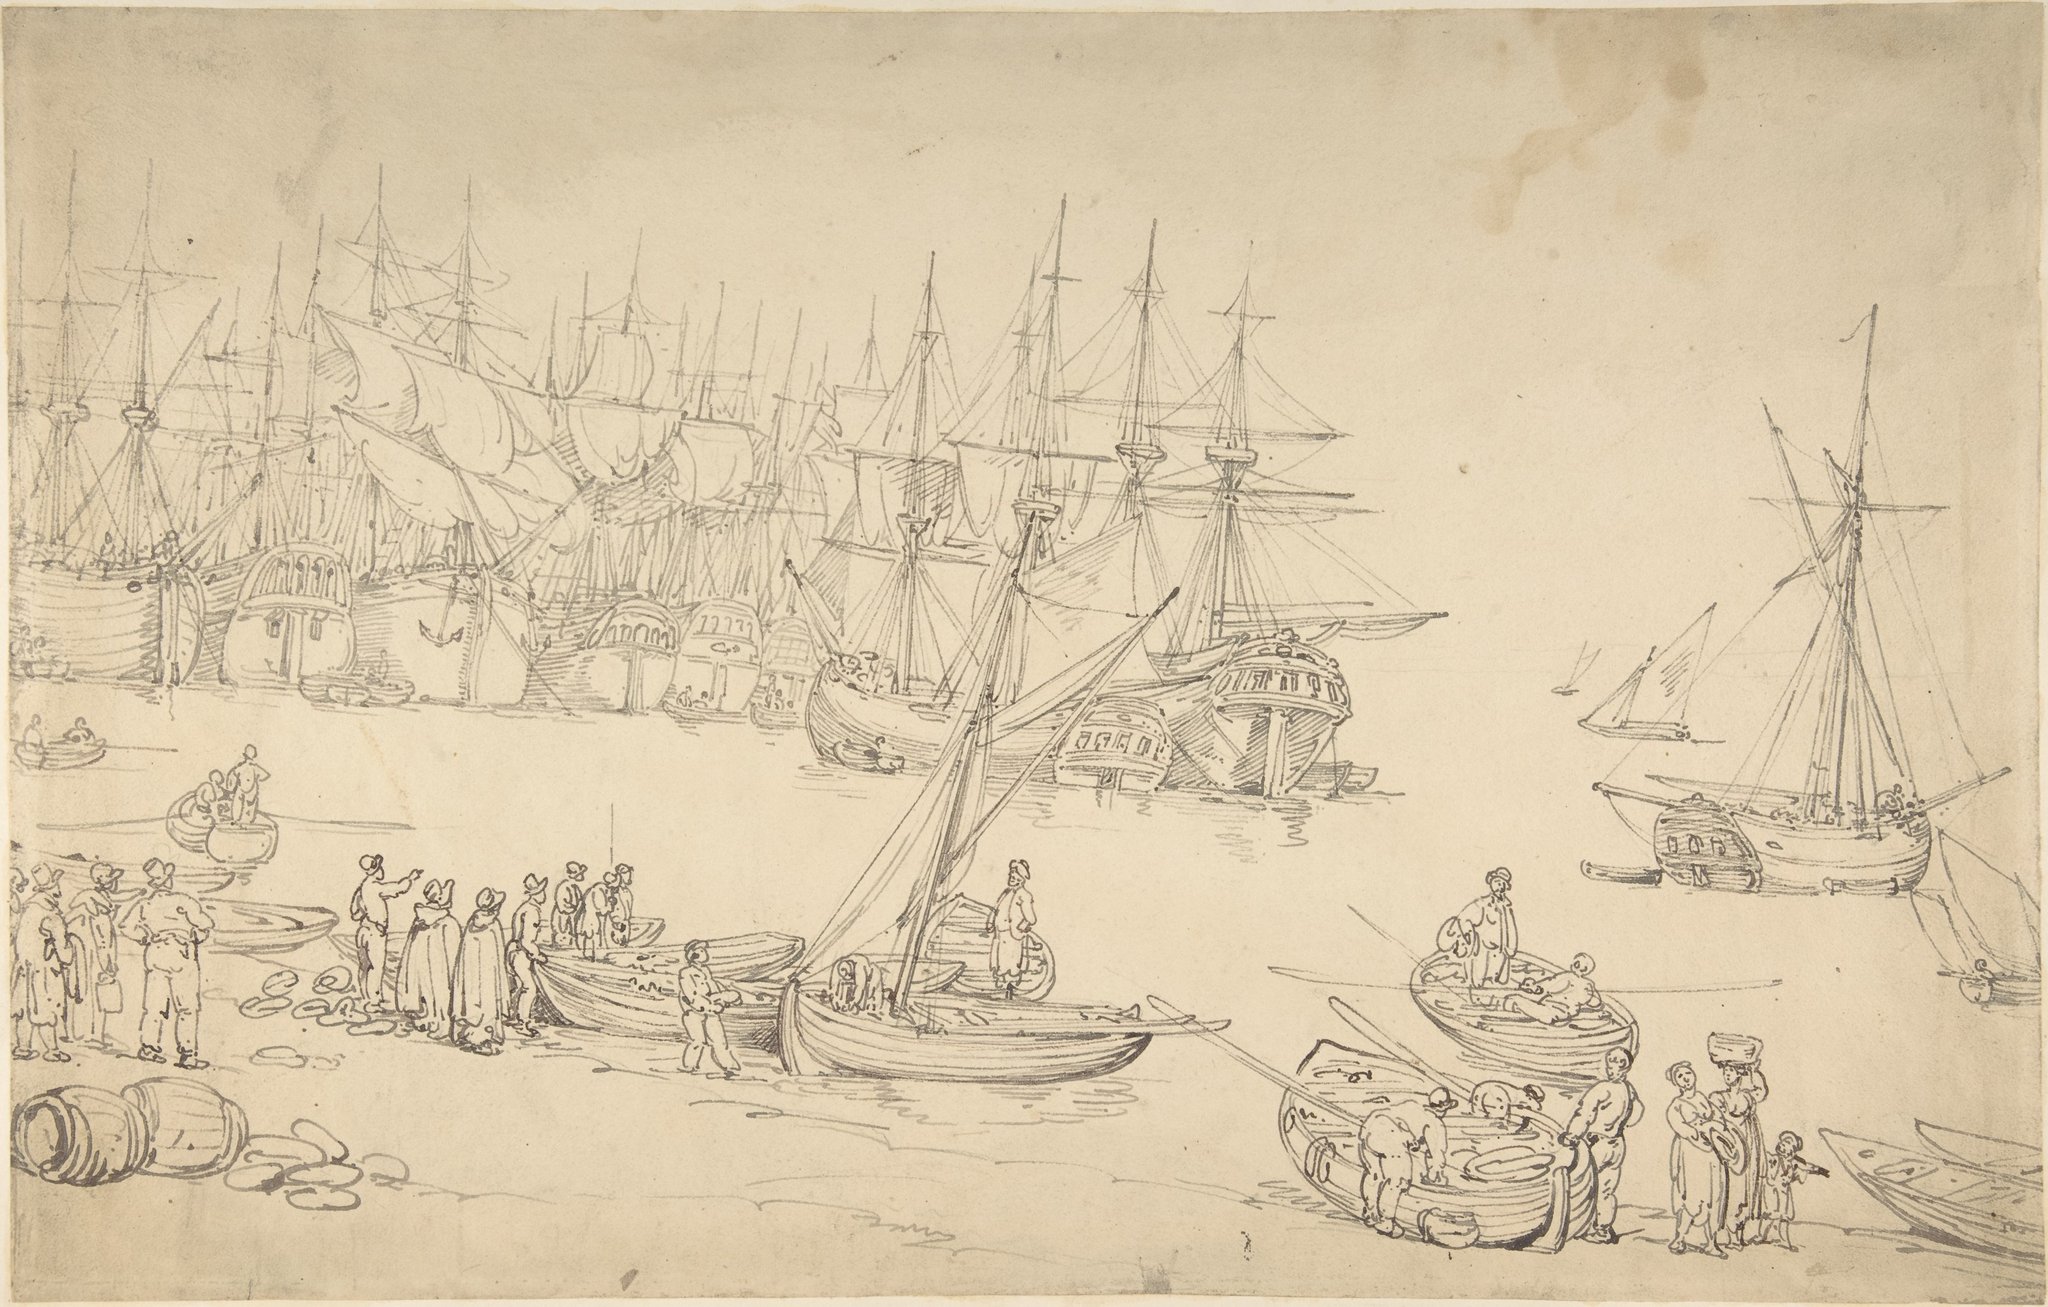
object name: drawing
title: Harbor scene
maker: thomas rowlandson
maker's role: artist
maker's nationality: british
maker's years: 1757-1827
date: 1775-1827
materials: ink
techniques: pen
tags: human figures,boats,ships